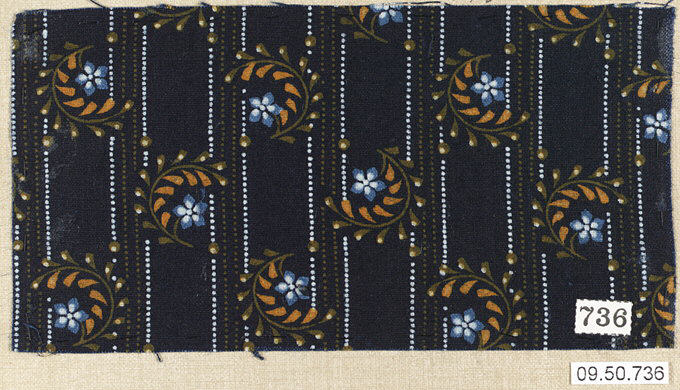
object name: piece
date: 1801-1900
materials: cotton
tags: flowers,leaves